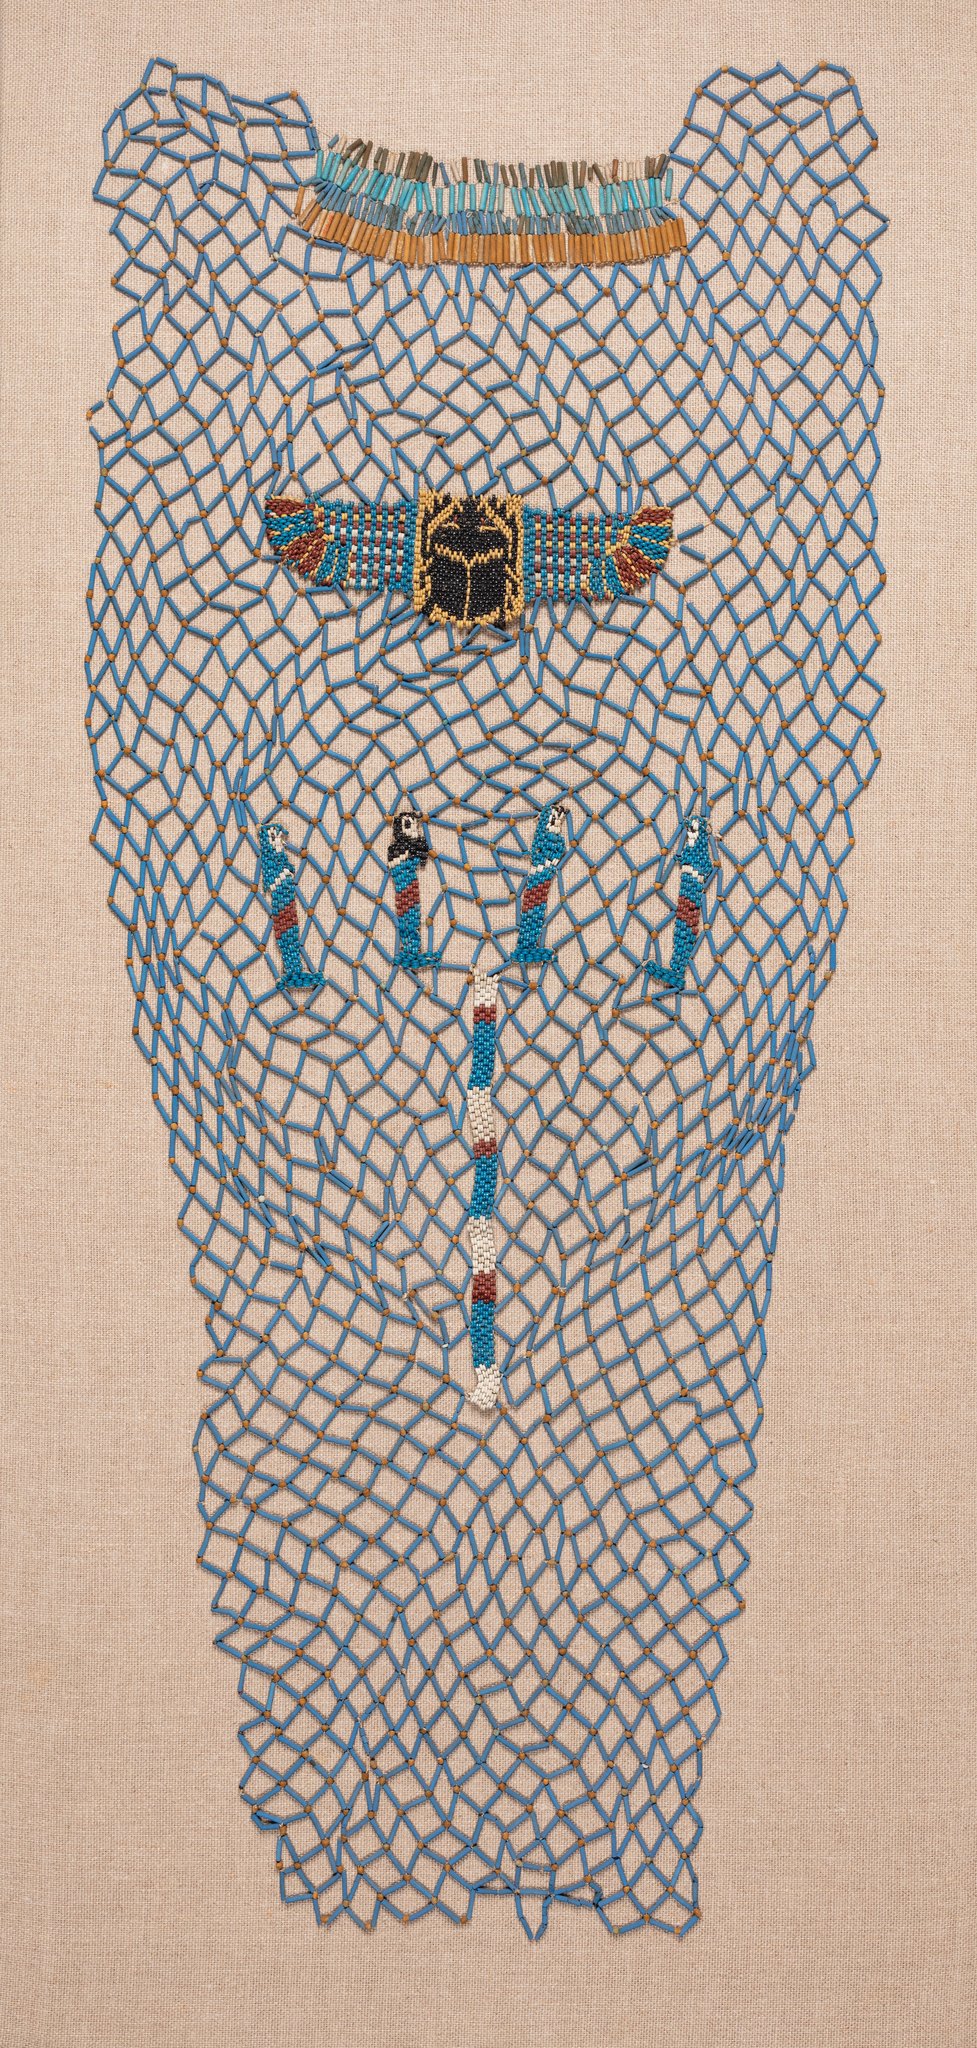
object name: beadwork shroud, tabakenkhonsu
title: Bead Shroud of Tabakenkhonsu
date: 680-670 BCE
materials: faience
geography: egypt